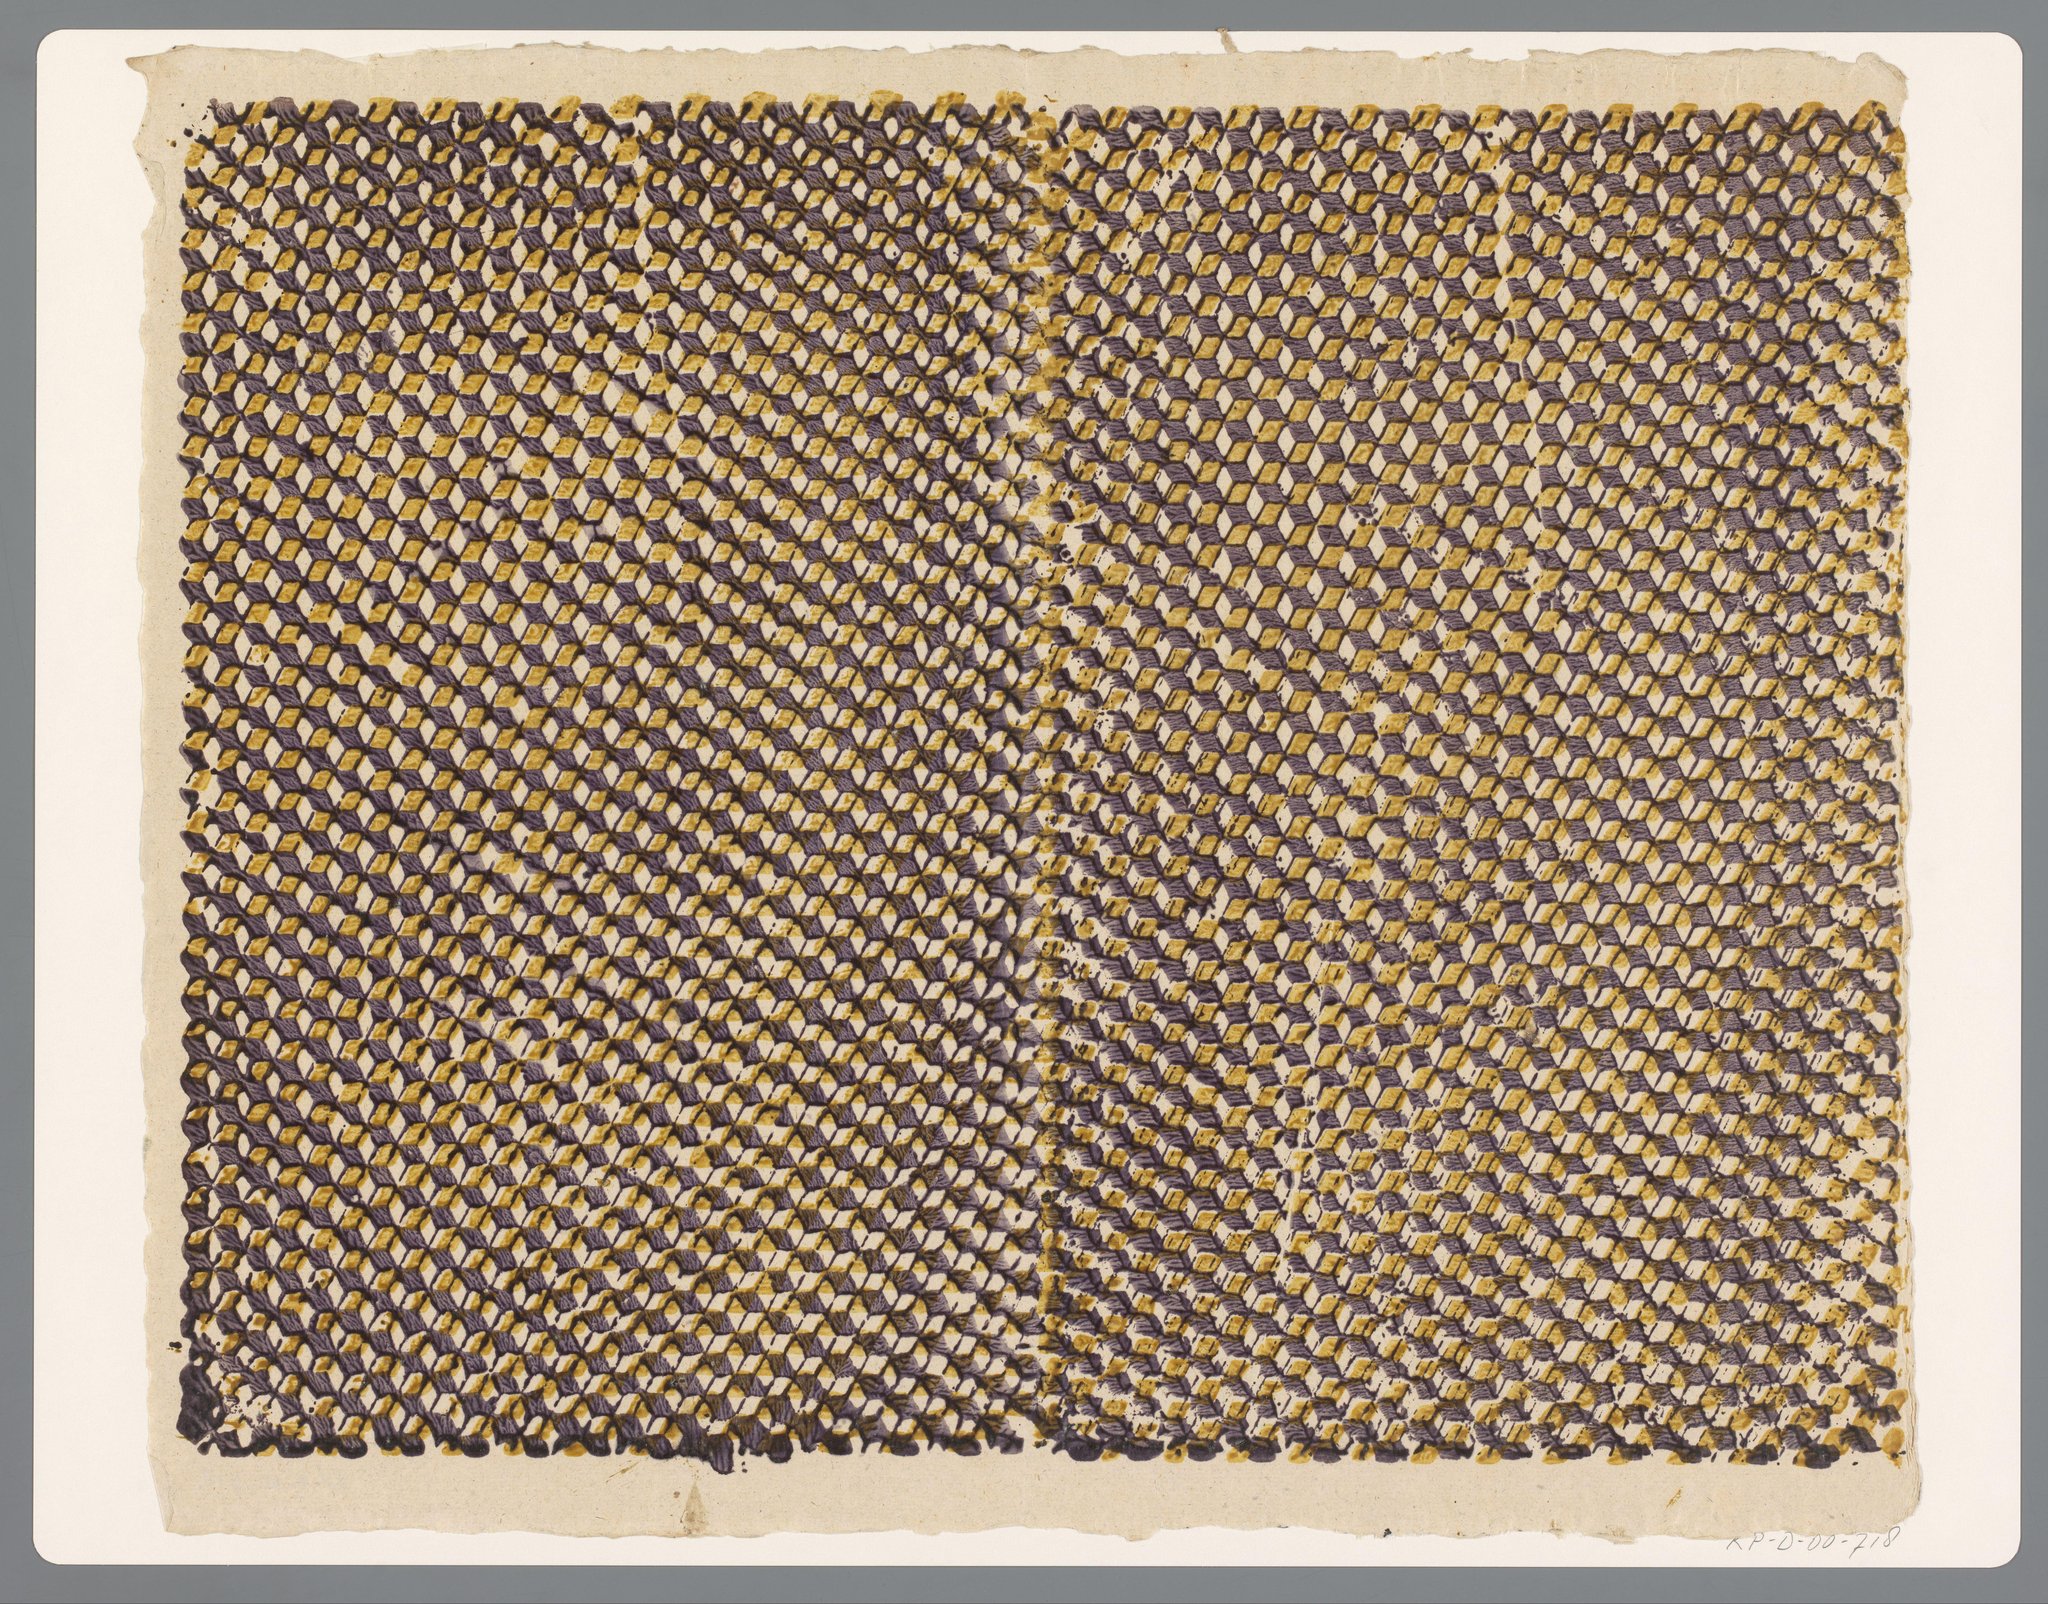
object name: printed paper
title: Blad met geometrisch blokkenpatroon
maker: Anonymous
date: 1750-1900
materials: lacquer, paper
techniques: printing block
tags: ornament ~ geometric motifs